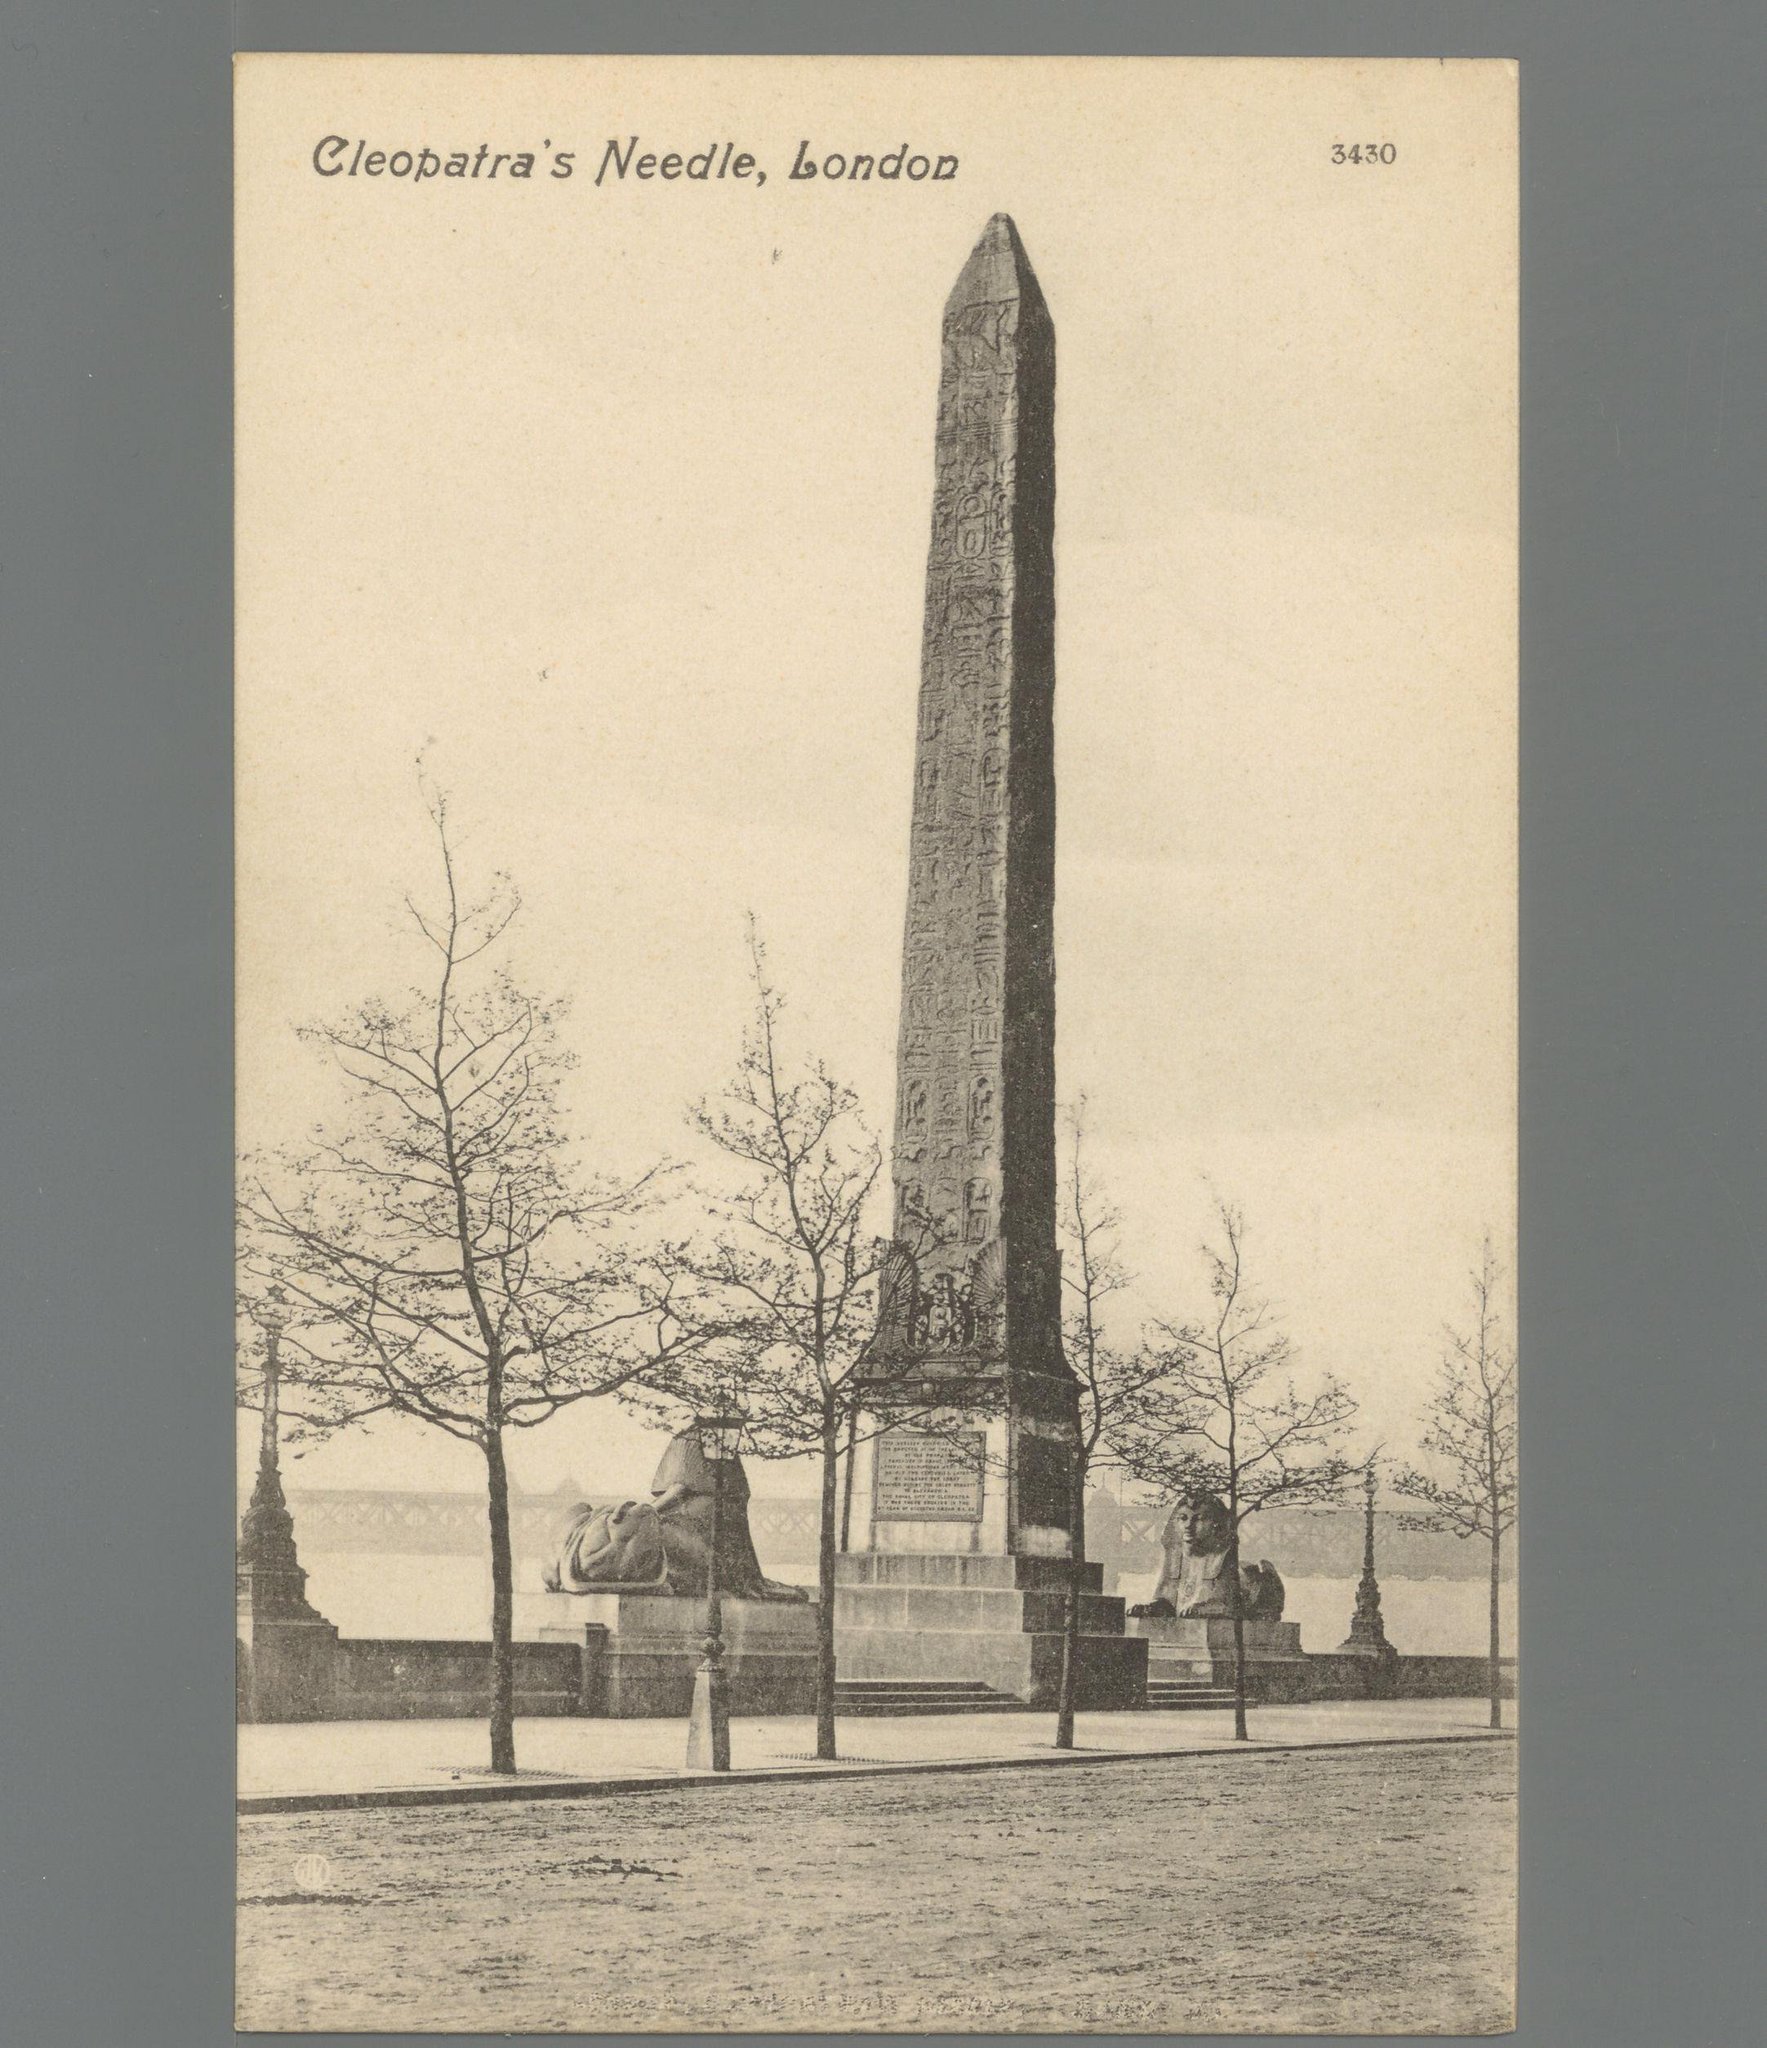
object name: ansichtkaart, prentbriefkaart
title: Cleopatra's Needle, London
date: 1902-1930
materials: cardboard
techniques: photograph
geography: great britain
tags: obelisk, needle, sphinx (lion/woman); 'sfinge' (ripa), canals, waters (in city), thames